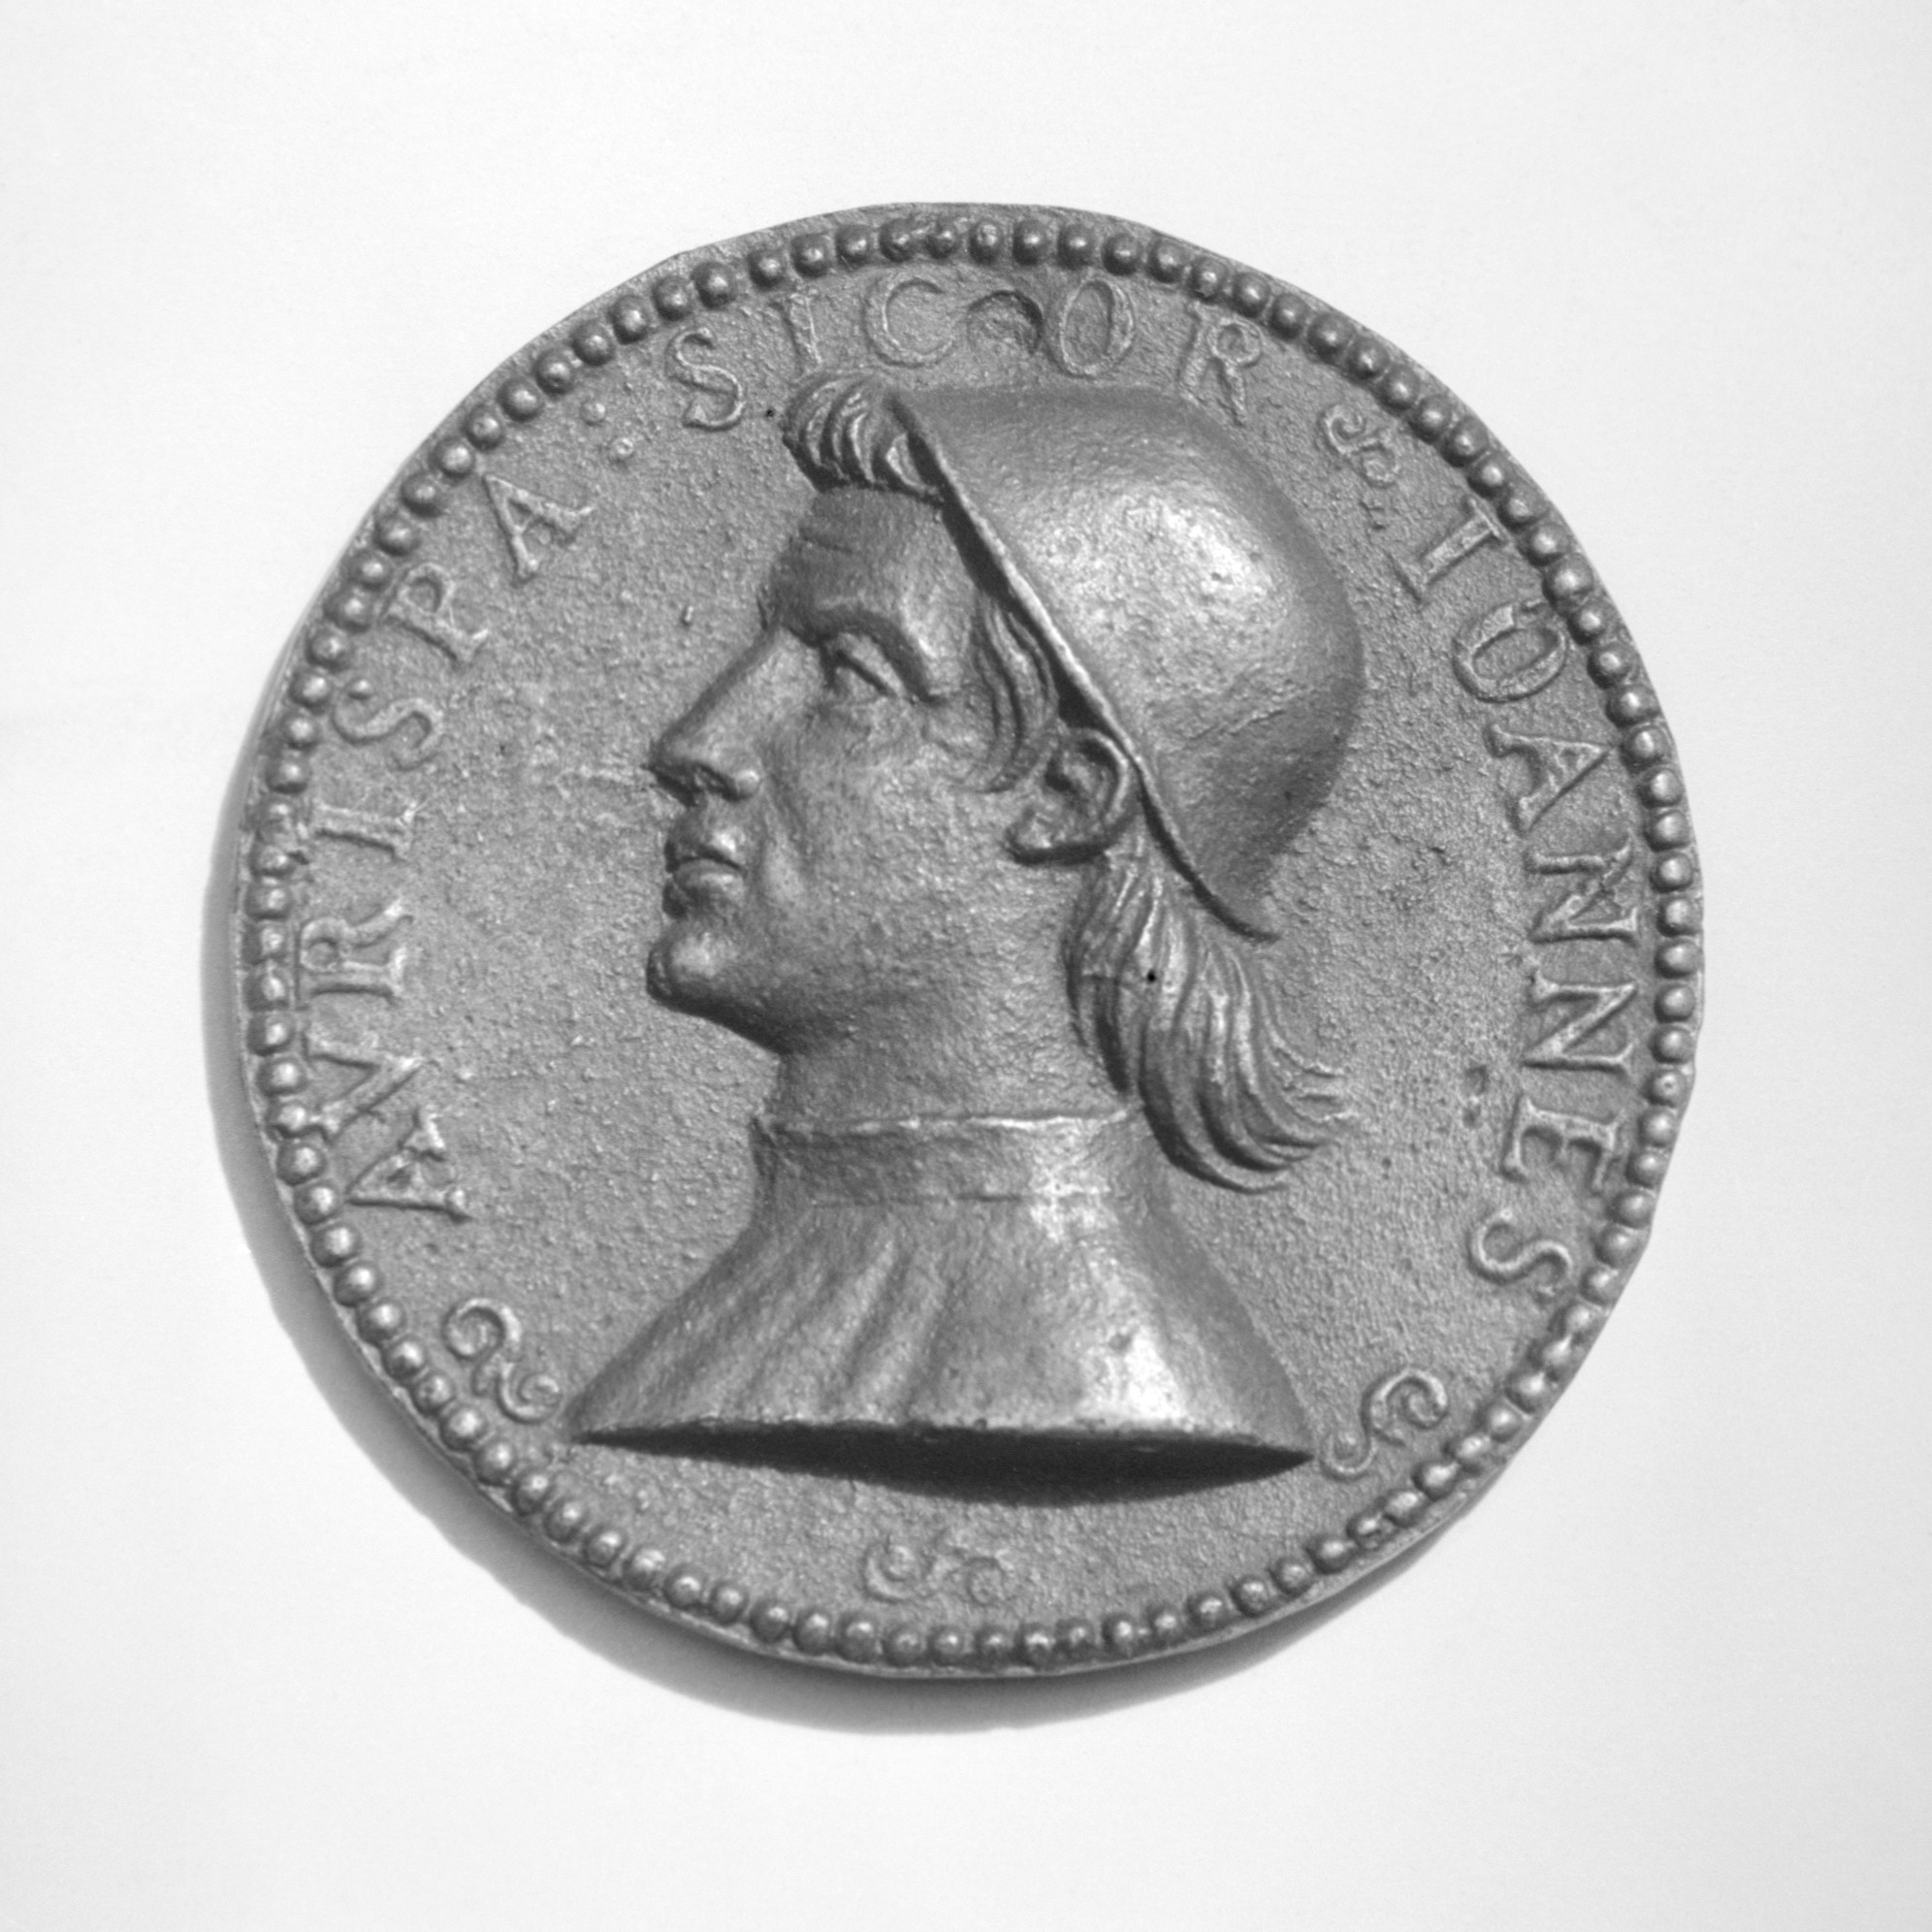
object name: medal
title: Giovanni Aurispa, Secretary to Popes Eugene IV and Nicholas V (ca. 1369–1459)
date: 1501-1600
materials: bronze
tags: men,profiles